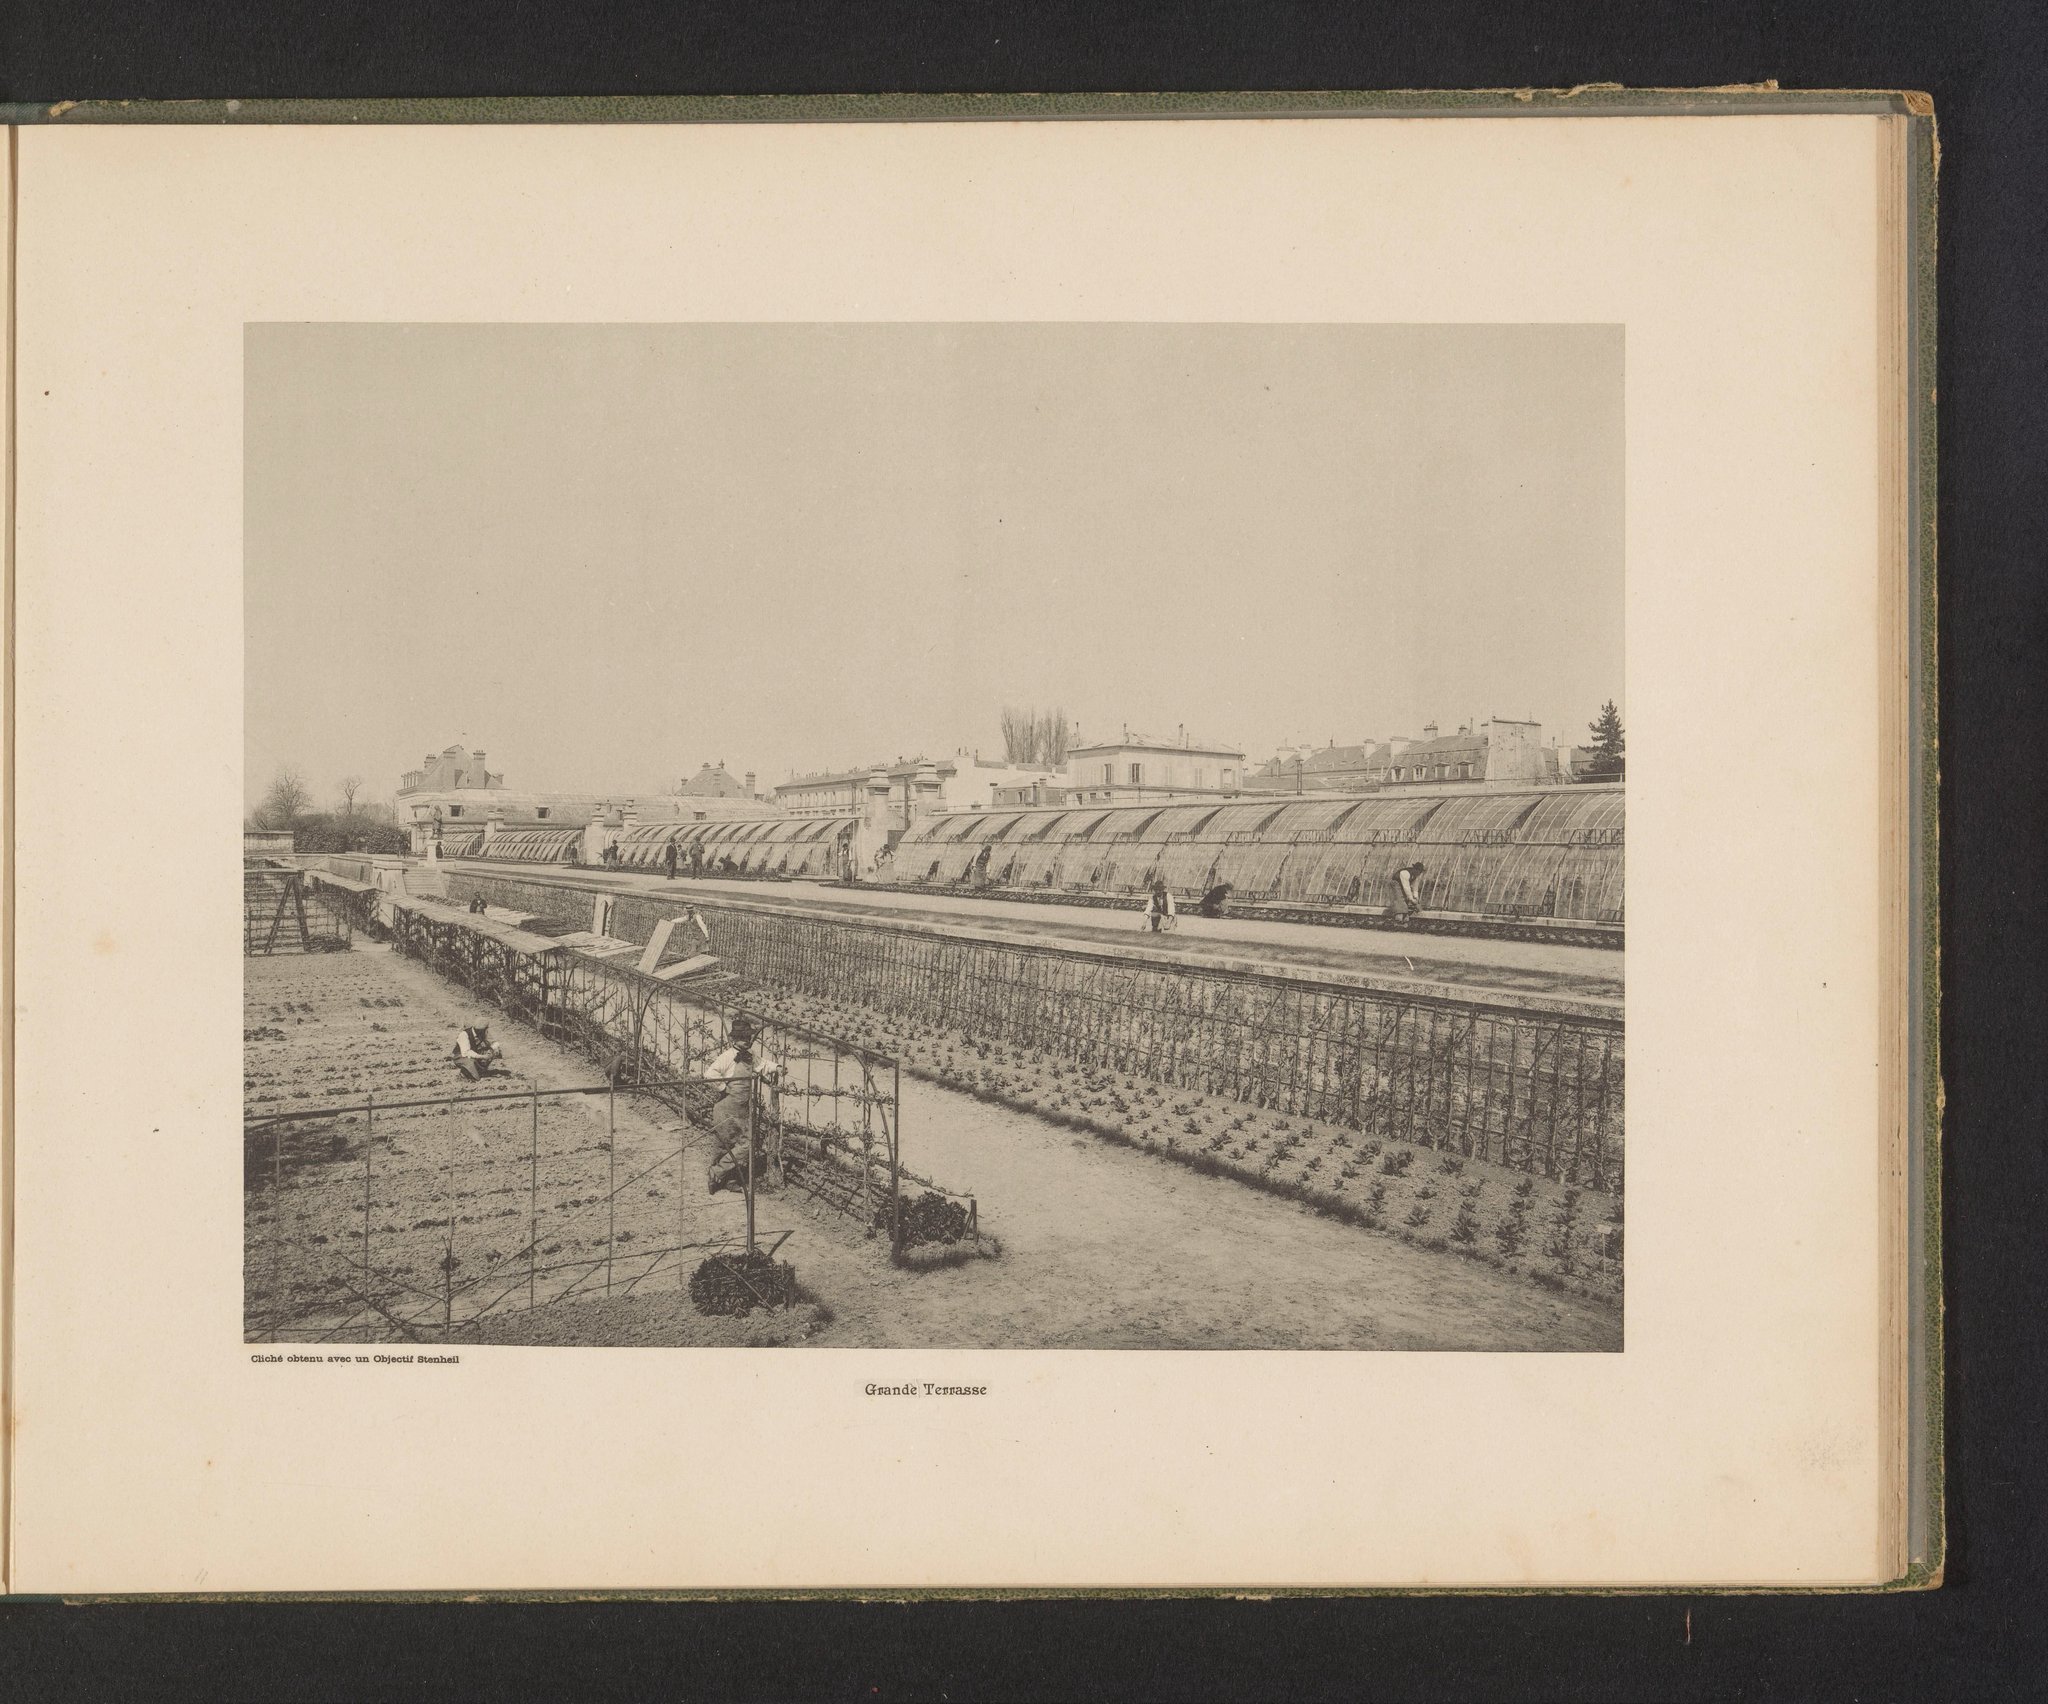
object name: page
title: Gezicht op een veld van de École Nationale Superieure d'Horticulture in Versailles, Frankrijk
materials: paper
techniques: photograph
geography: versailles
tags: field filled with a crop, horticulture, vegetable culture, market gardening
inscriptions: inscription: ‘Cliché obtenu avec un Objectif Stenheil’